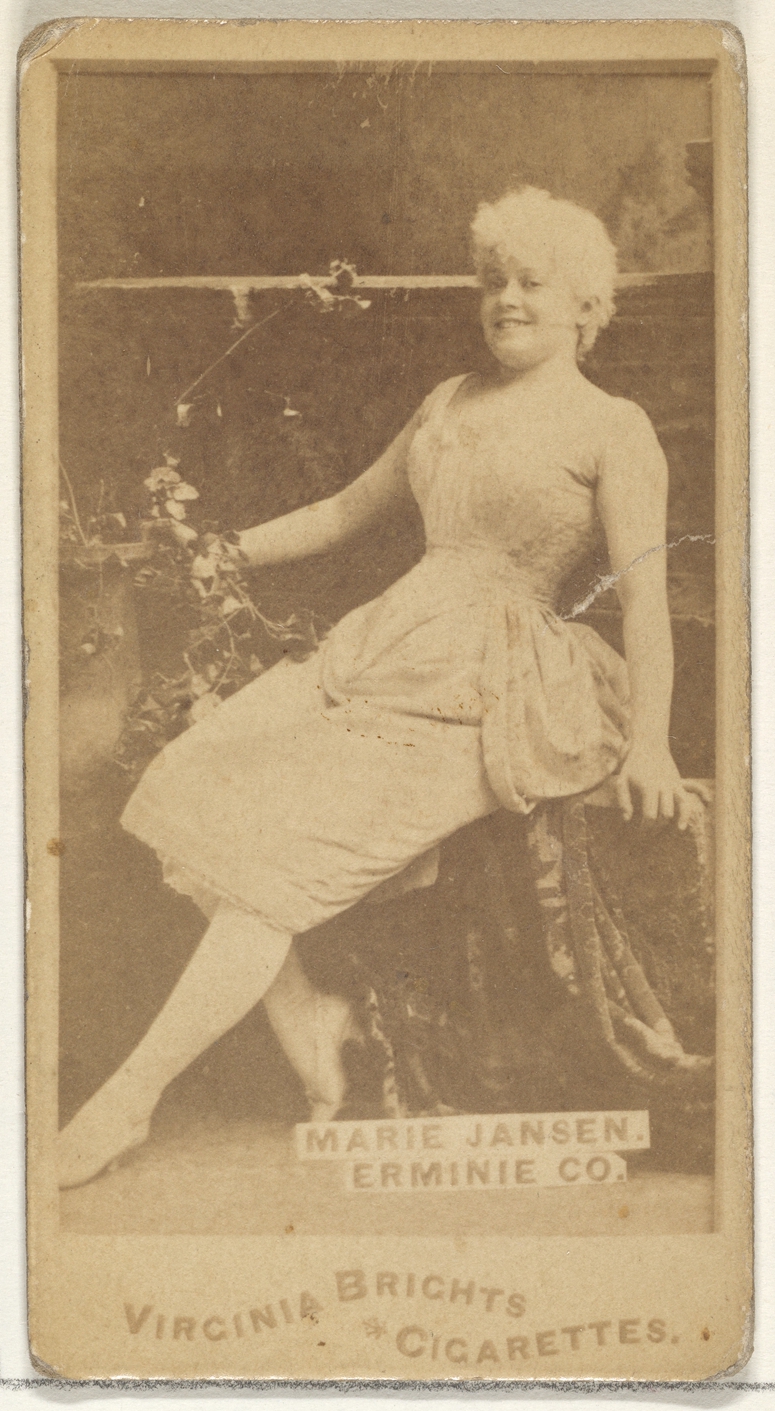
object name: photograph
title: Marie Janson, Erminie Co., from the Actors and Actresses series (N45, Type 1) for Virginia Brights Cigarettes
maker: allen & ginter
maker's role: publisher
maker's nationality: american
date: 1888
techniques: albumen silver print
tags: portraits,women,actresses